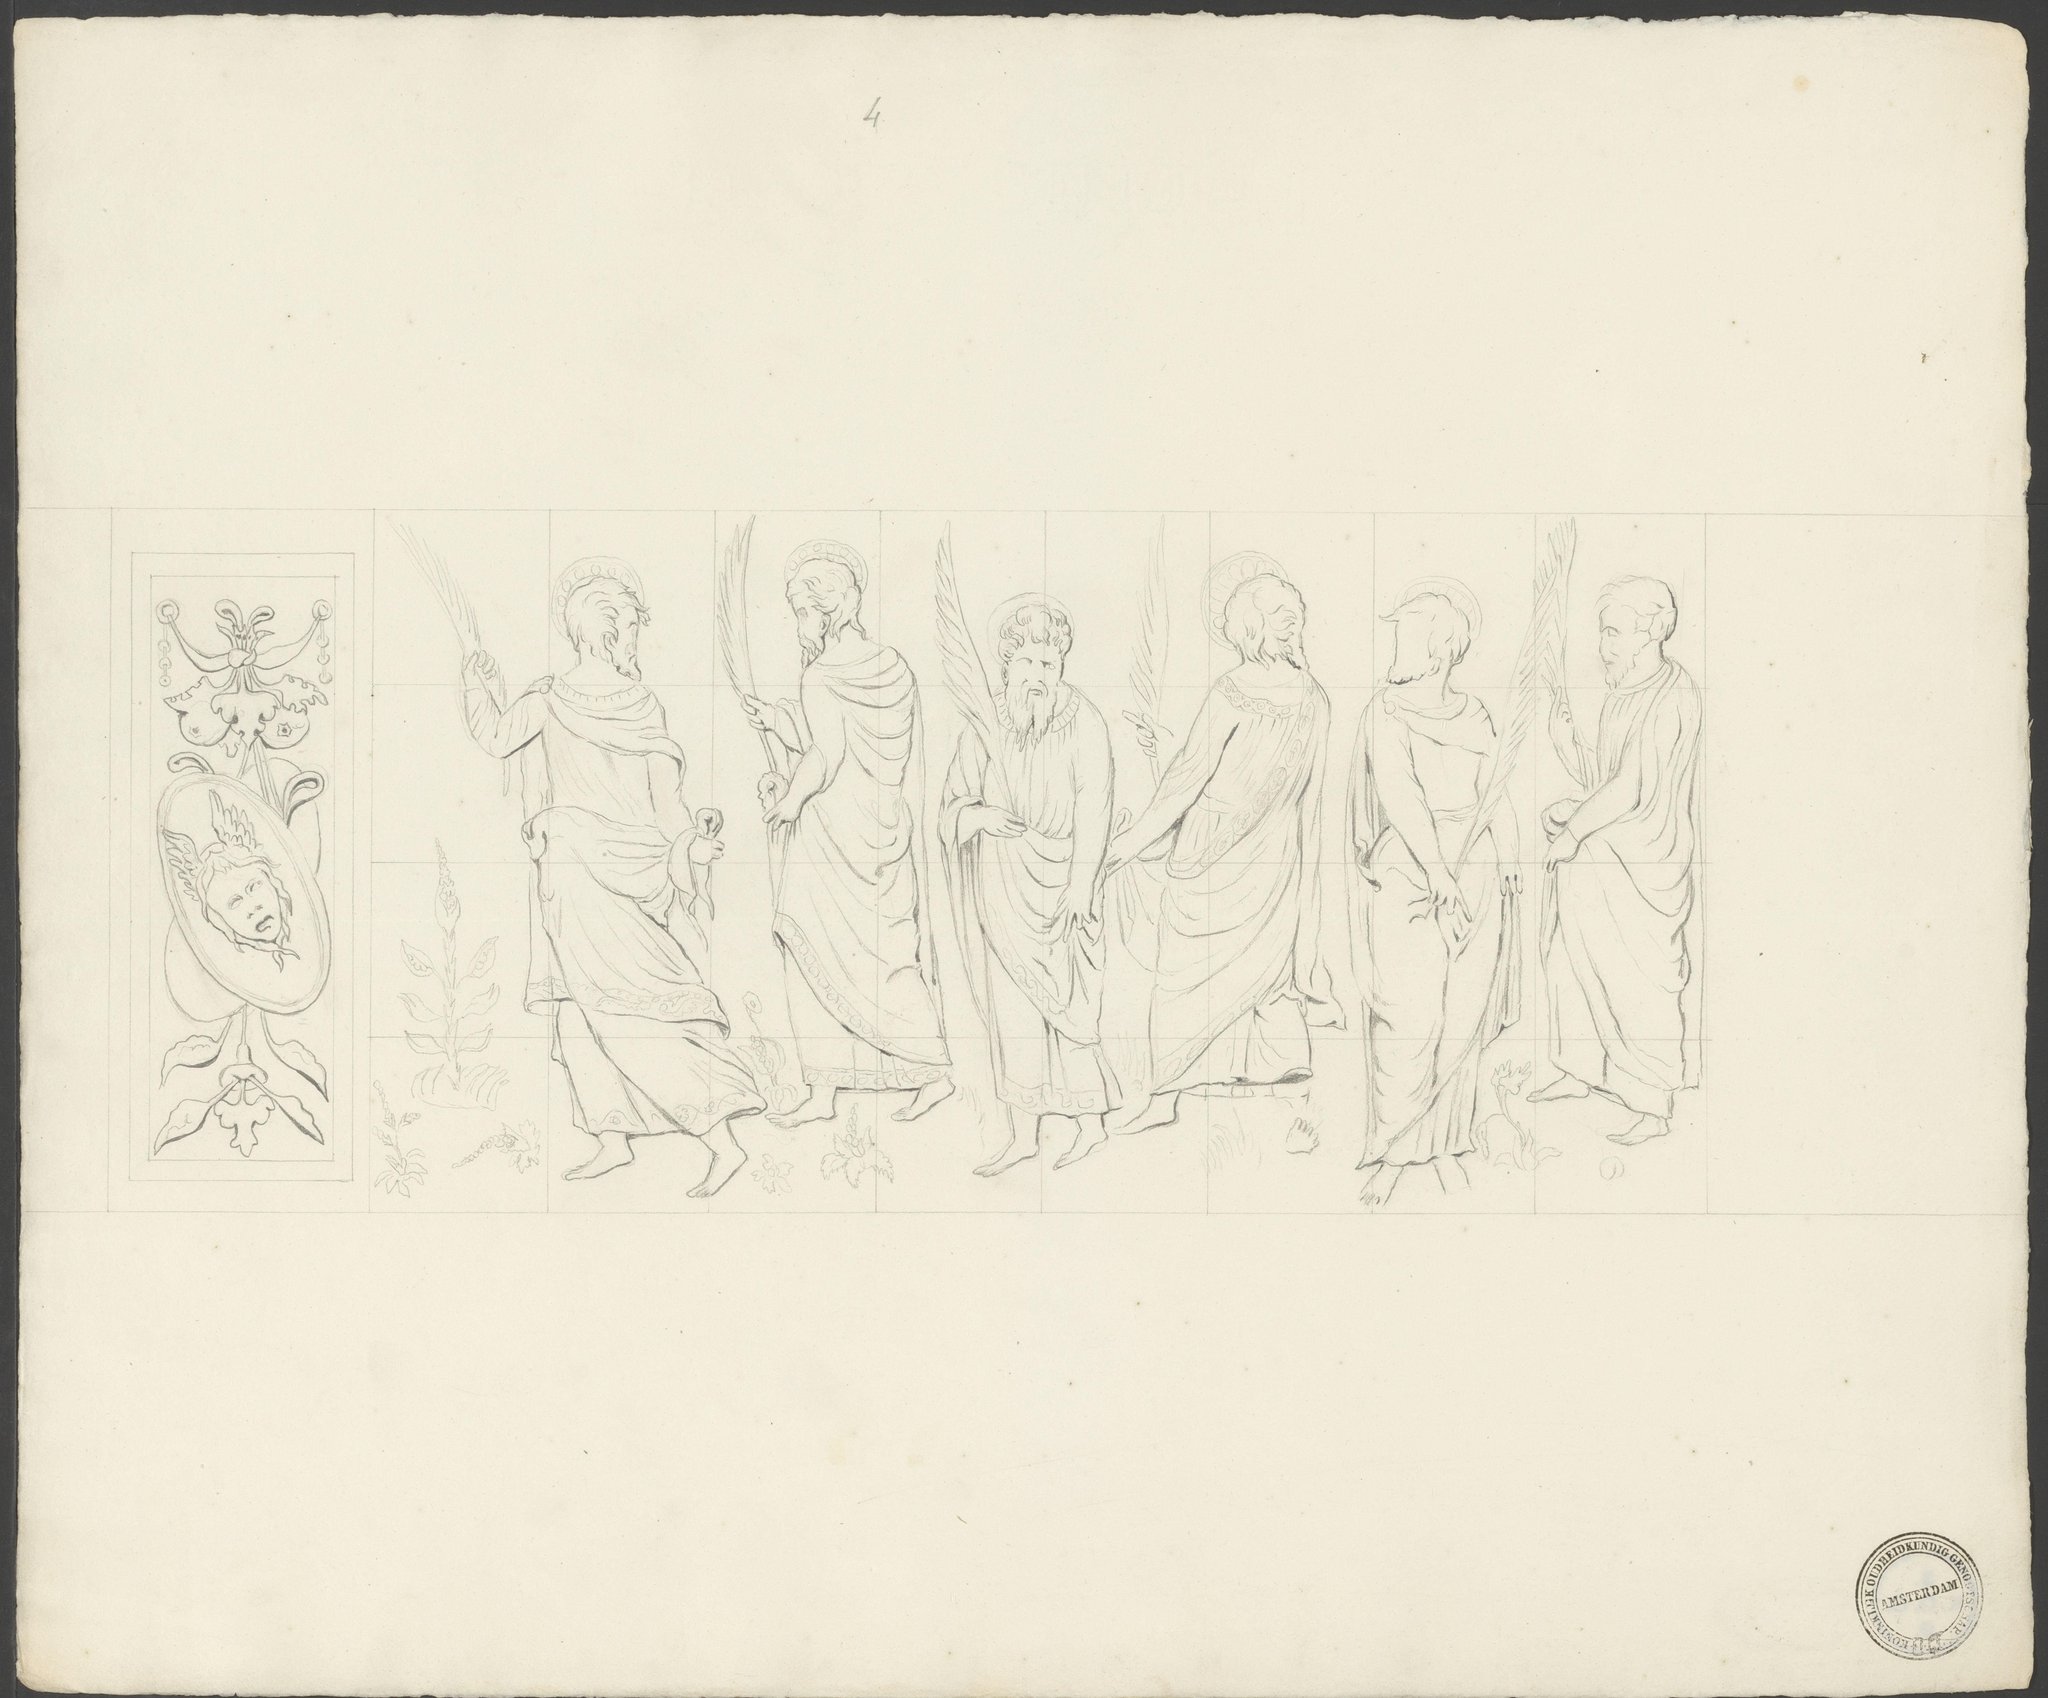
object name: drawing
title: Paneel met heiligen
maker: Anonymous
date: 1850-1940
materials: paper, pencil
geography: dordrecht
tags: carving ~ applied arts, piece of sculpture, reproduction of a piece of sculpture, wood carver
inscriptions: collector's mark: Lugt 1641, collector's mark, collector's mark: ‘Koninklijk Oudheidkundig Genootschap Amsterdam’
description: Paneel met heiligen met palmtakken. Onderdeel van een serie van 18 schetstekeningen naar het houtsnijwerk gemaakt door Jan Aertsz. Terwen in de jaren 1538-1542 voor de koorbanken in de Grote of Onze-Lieve-Vrouwekerk te Dordrecht. Genummerd bovenaan: 4. Onderwerpsrubrieken binnen de Atlas Zeden en Gewoonten: Beeldhouw- en snijkunst.